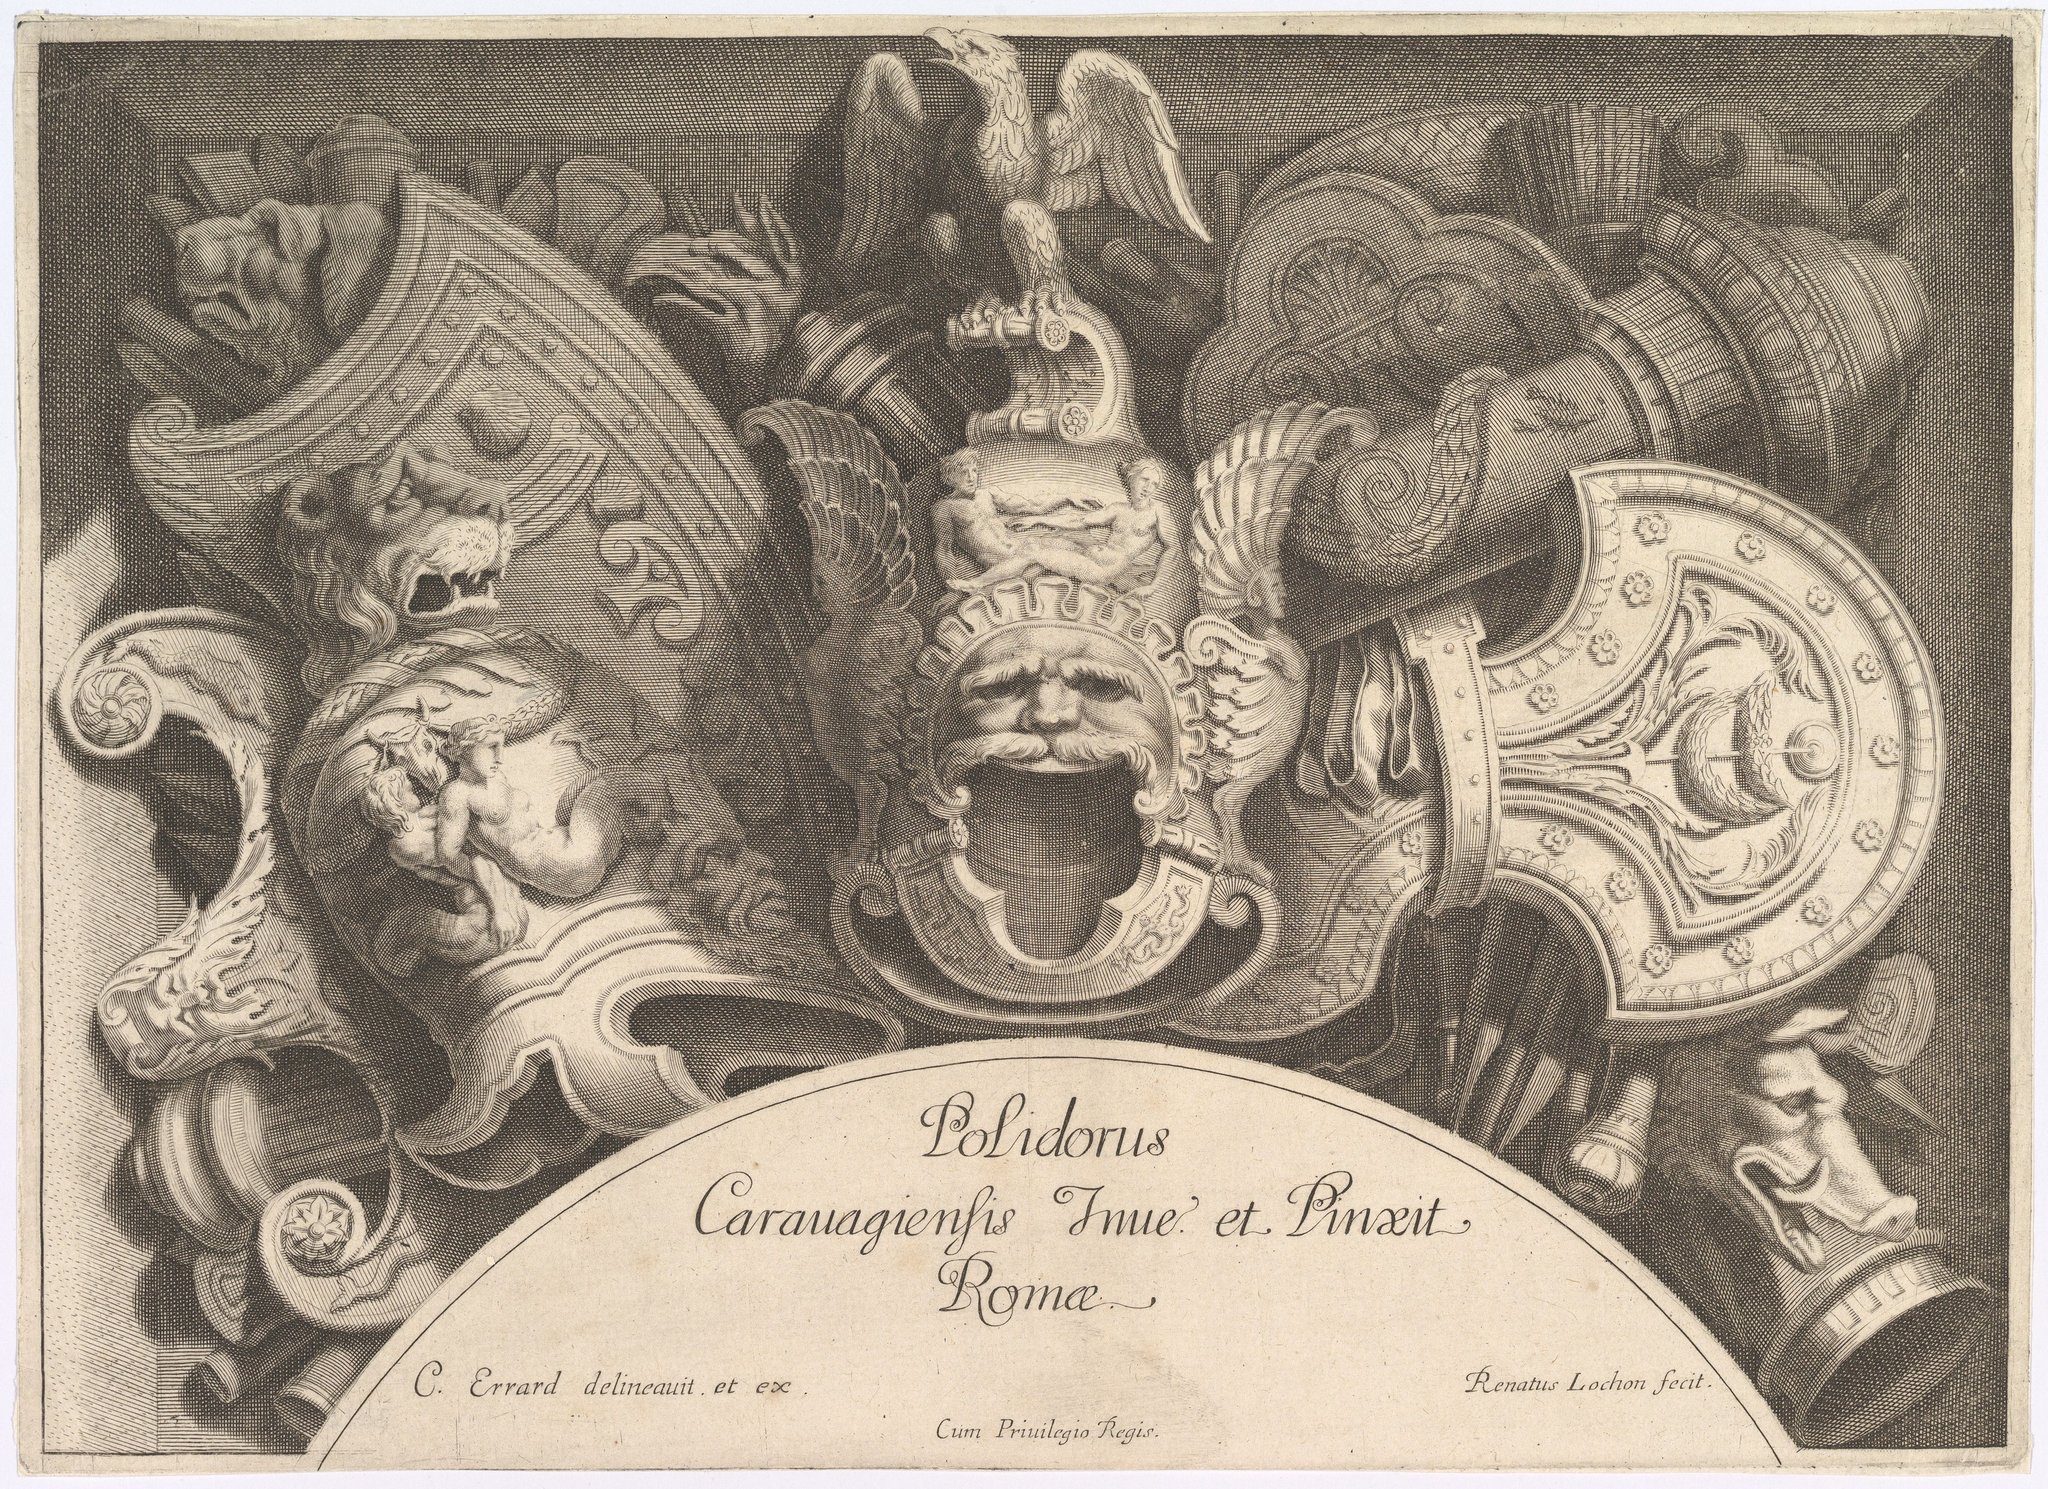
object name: print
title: Plate from "Divers Trophées" (Weapon Trophies after the Façade of Palazzo Milesi in Rome)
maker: polidoro da caravaggio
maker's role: artist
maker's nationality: italian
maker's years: 1494-1548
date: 1651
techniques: engraving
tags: eagles,weapons,trophies